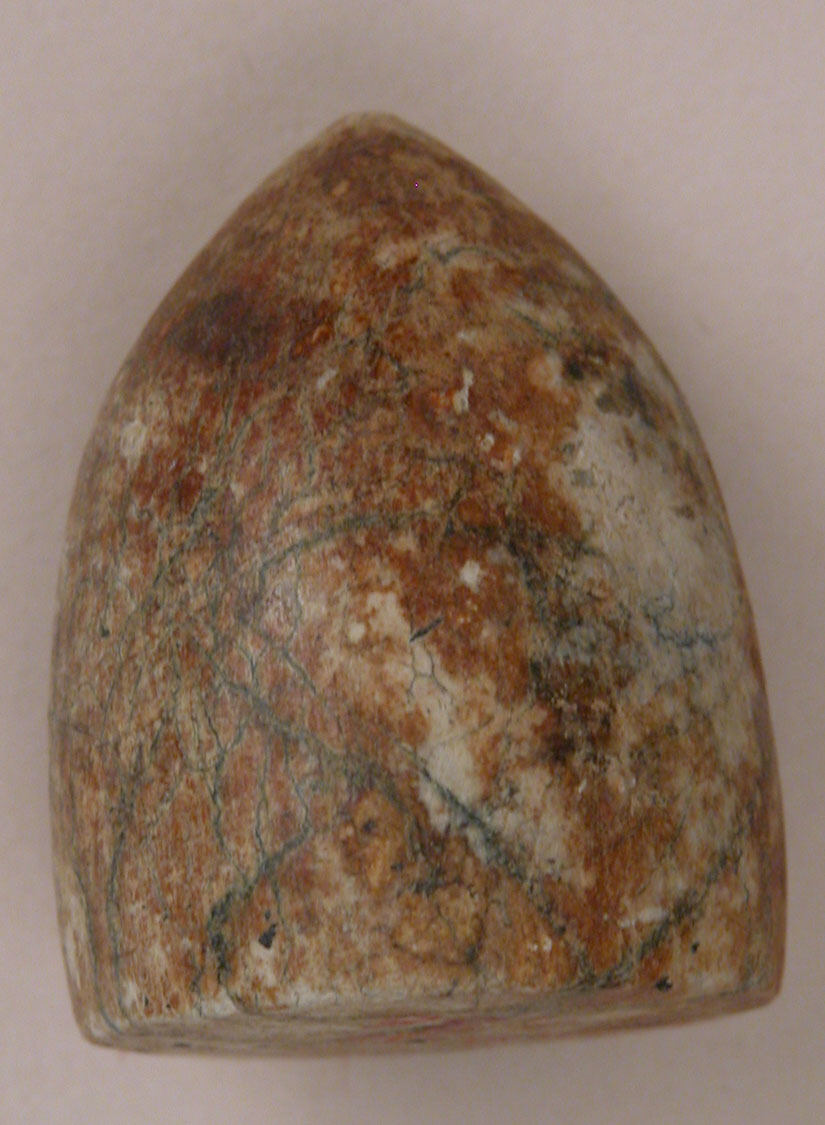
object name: gaming or chess piece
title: Gaming or Chess Piece, Possibly a Pawn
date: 701-1100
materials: stone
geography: western islamic lands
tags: games